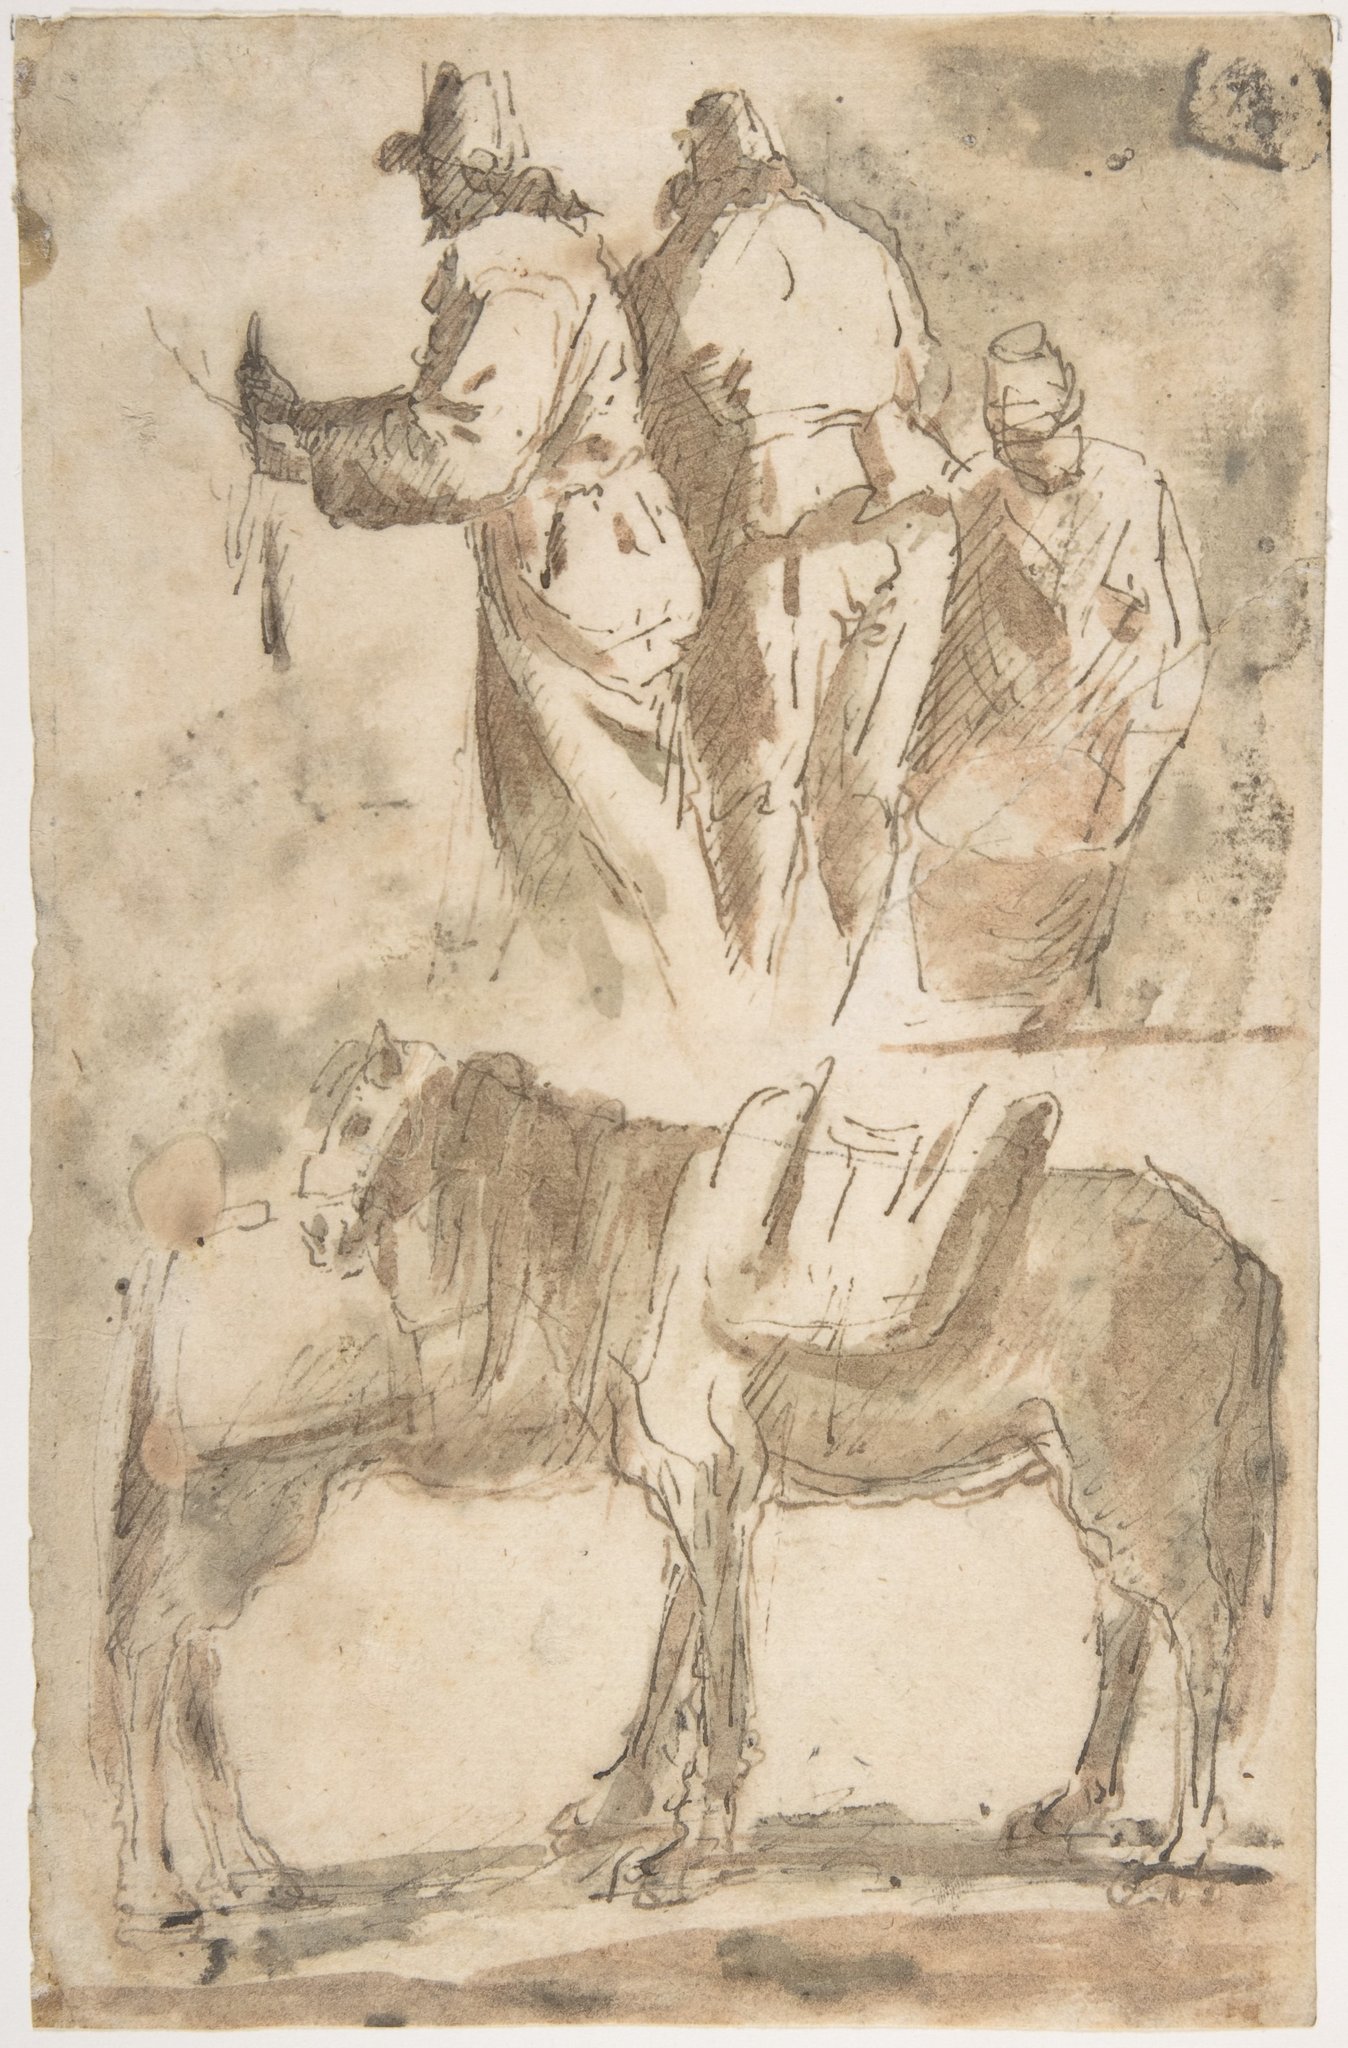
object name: drawing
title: Sheet of Studies: Three Figures Above, Studies of Horses Below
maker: micco spadaro (domenico gargiulo)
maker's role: artist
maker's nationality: italian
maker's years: 1609-1675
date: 1612-1675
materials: ink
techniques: brush, pen, wash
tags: men,horses